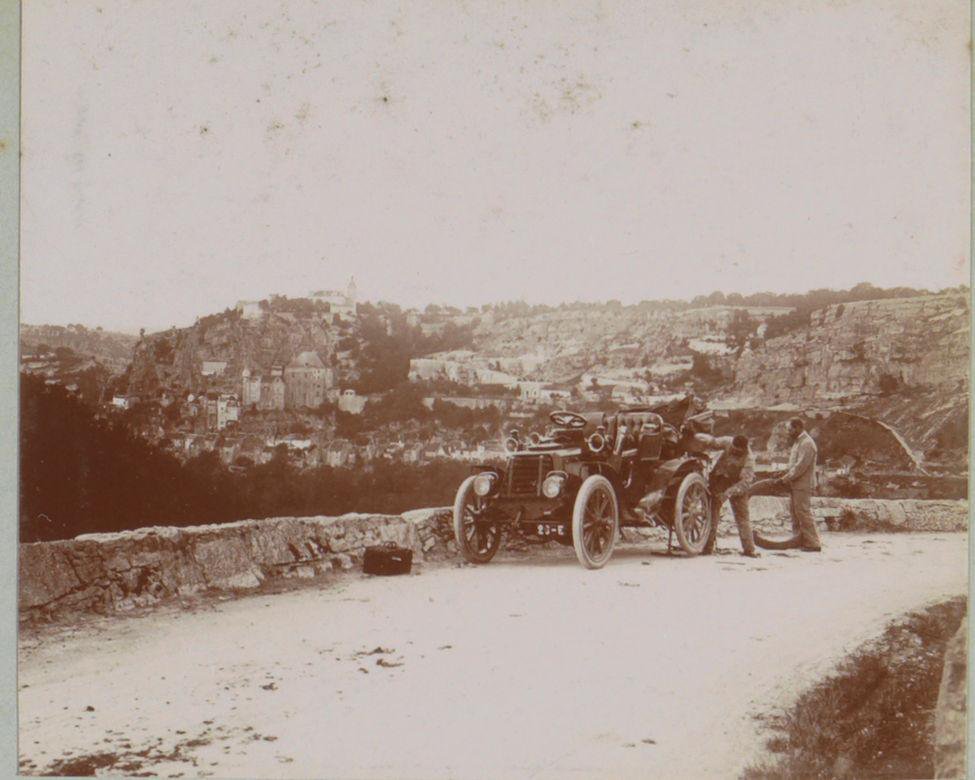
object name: photograph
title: Bandenwissel van automobiel op een weg bij Rocamadour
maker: delizy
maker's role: manufacturer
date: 1903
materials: paper, photographic support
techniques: gelatin silver print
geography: rocamadour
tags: maintenance, repair, storage ~ motor vehicles, road, path, automobile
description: Onderdeel van Fotoalbum van een Franse amateurfotograaf met opnames van uitstapjes in Frankrijk, Spanje, België, Luxemburg en Nederland, de eerste automobielen en autoraces.